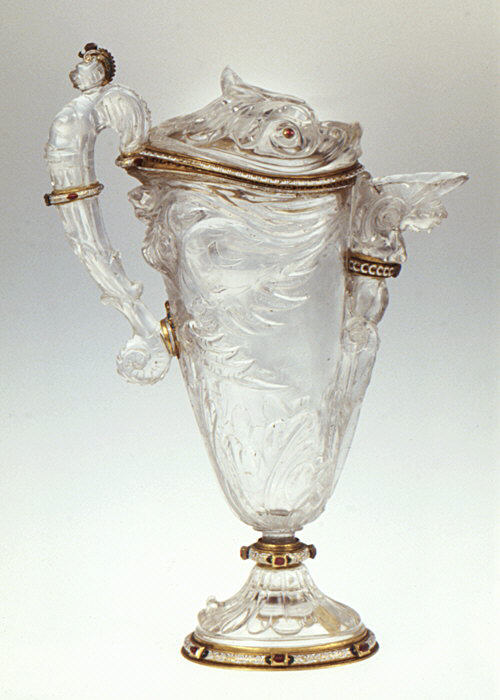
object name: ewer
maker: alfred andré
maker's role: maker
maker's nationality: french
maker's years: 1839-1919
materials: enamel, gold, quartz, gemstone